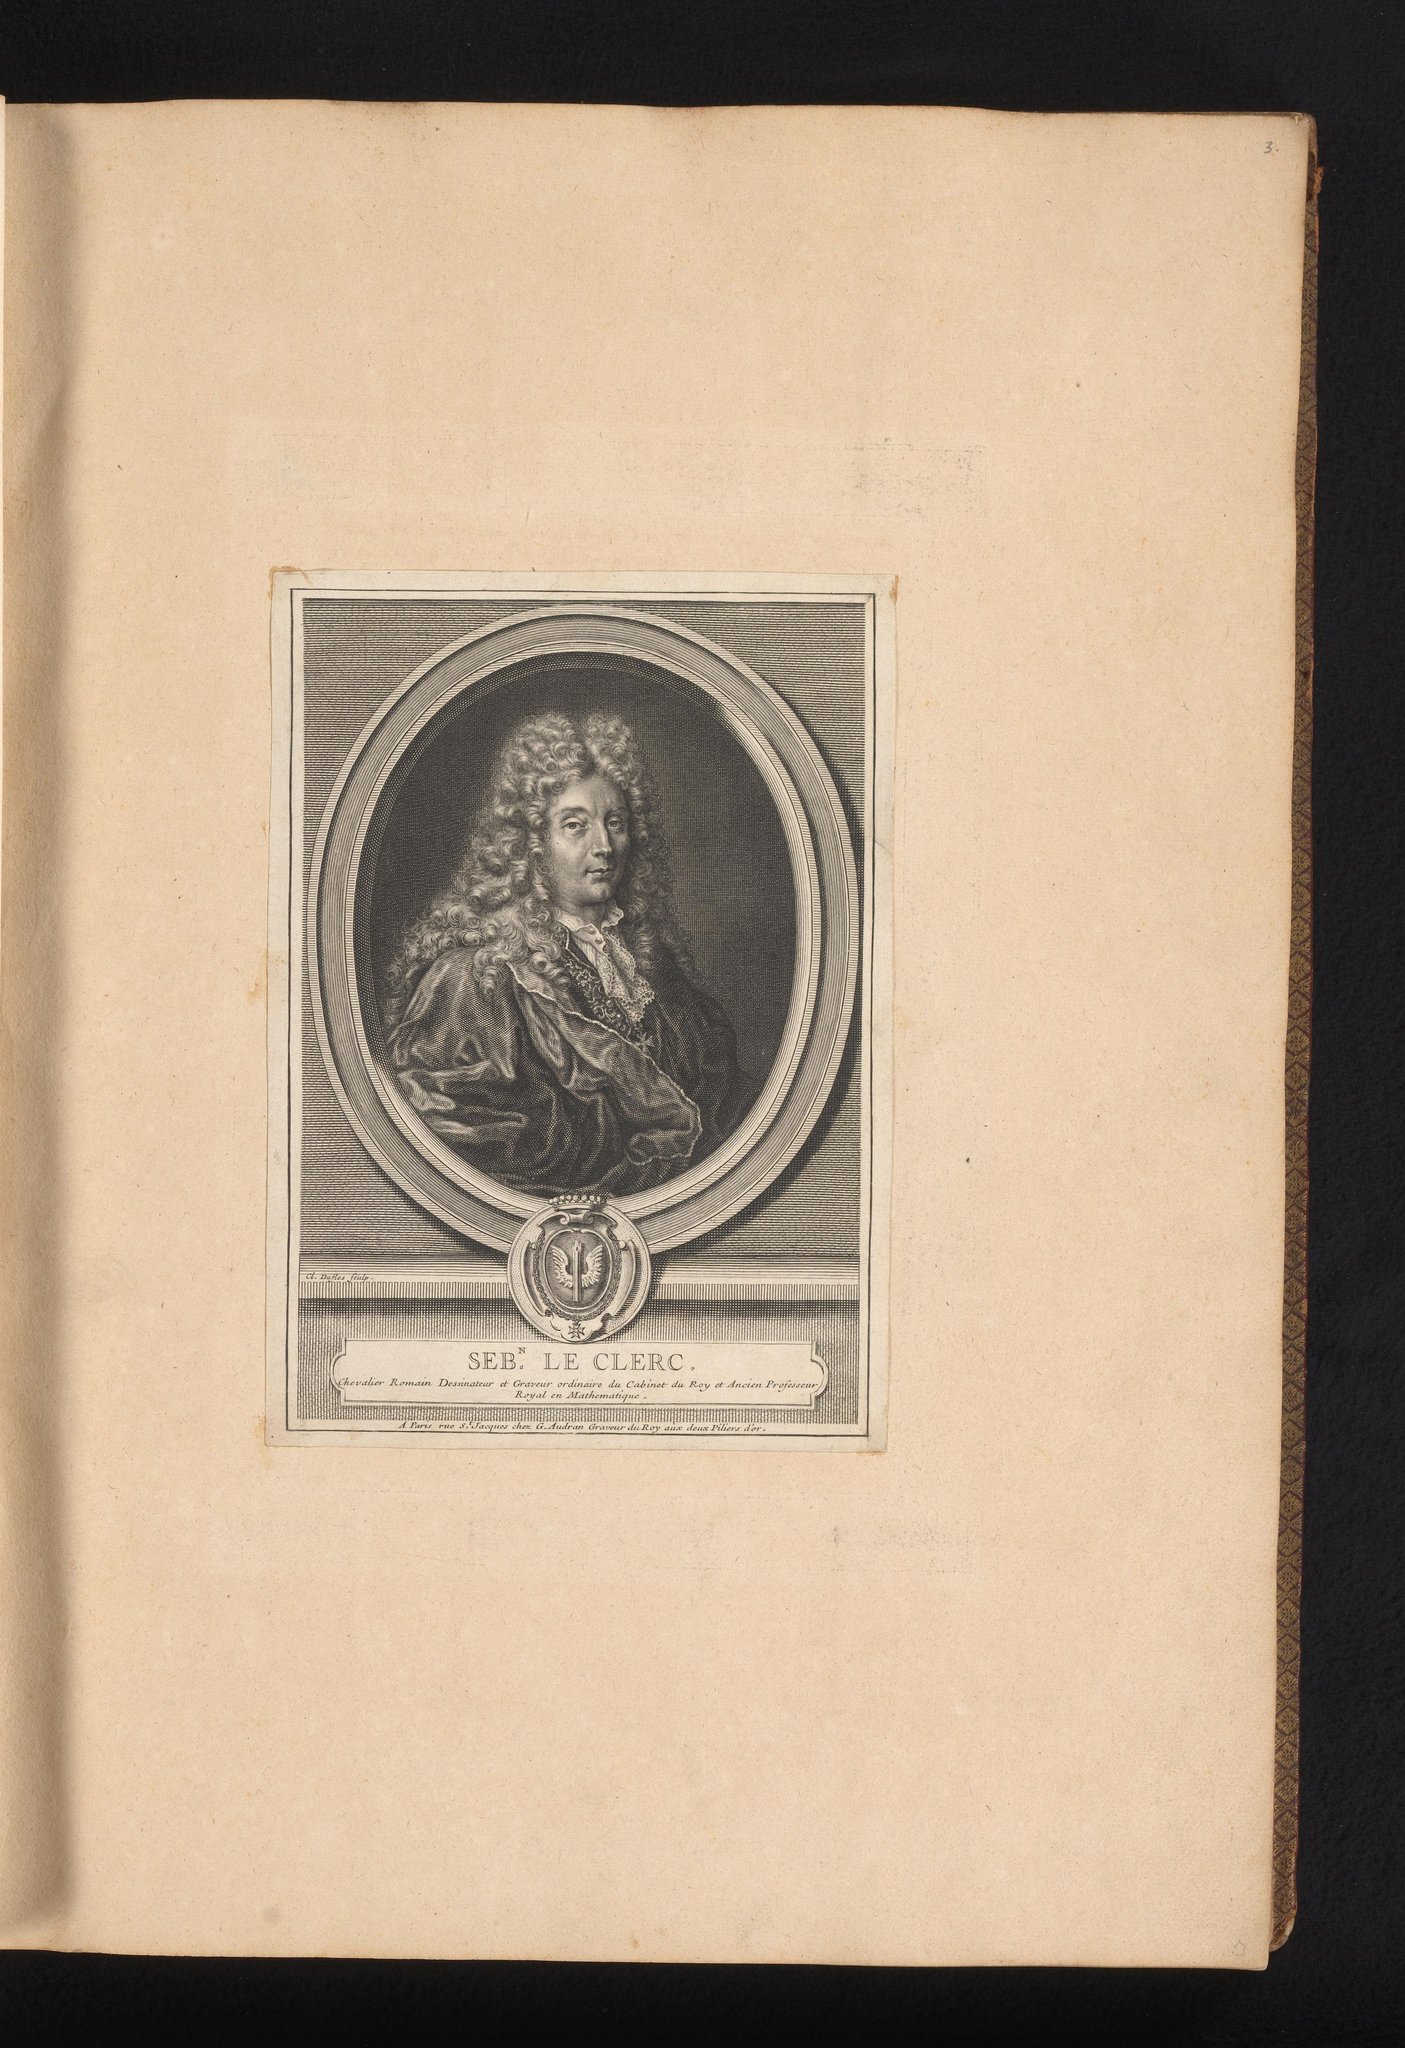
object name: album leaf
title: Portret van Sébastien (I) Leclerc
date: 1675-1703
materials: paper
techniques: engraving, etching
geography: paris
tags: paris, print maker, sébastien leclerc (i), historical persons, portrait, self-portrait of artist